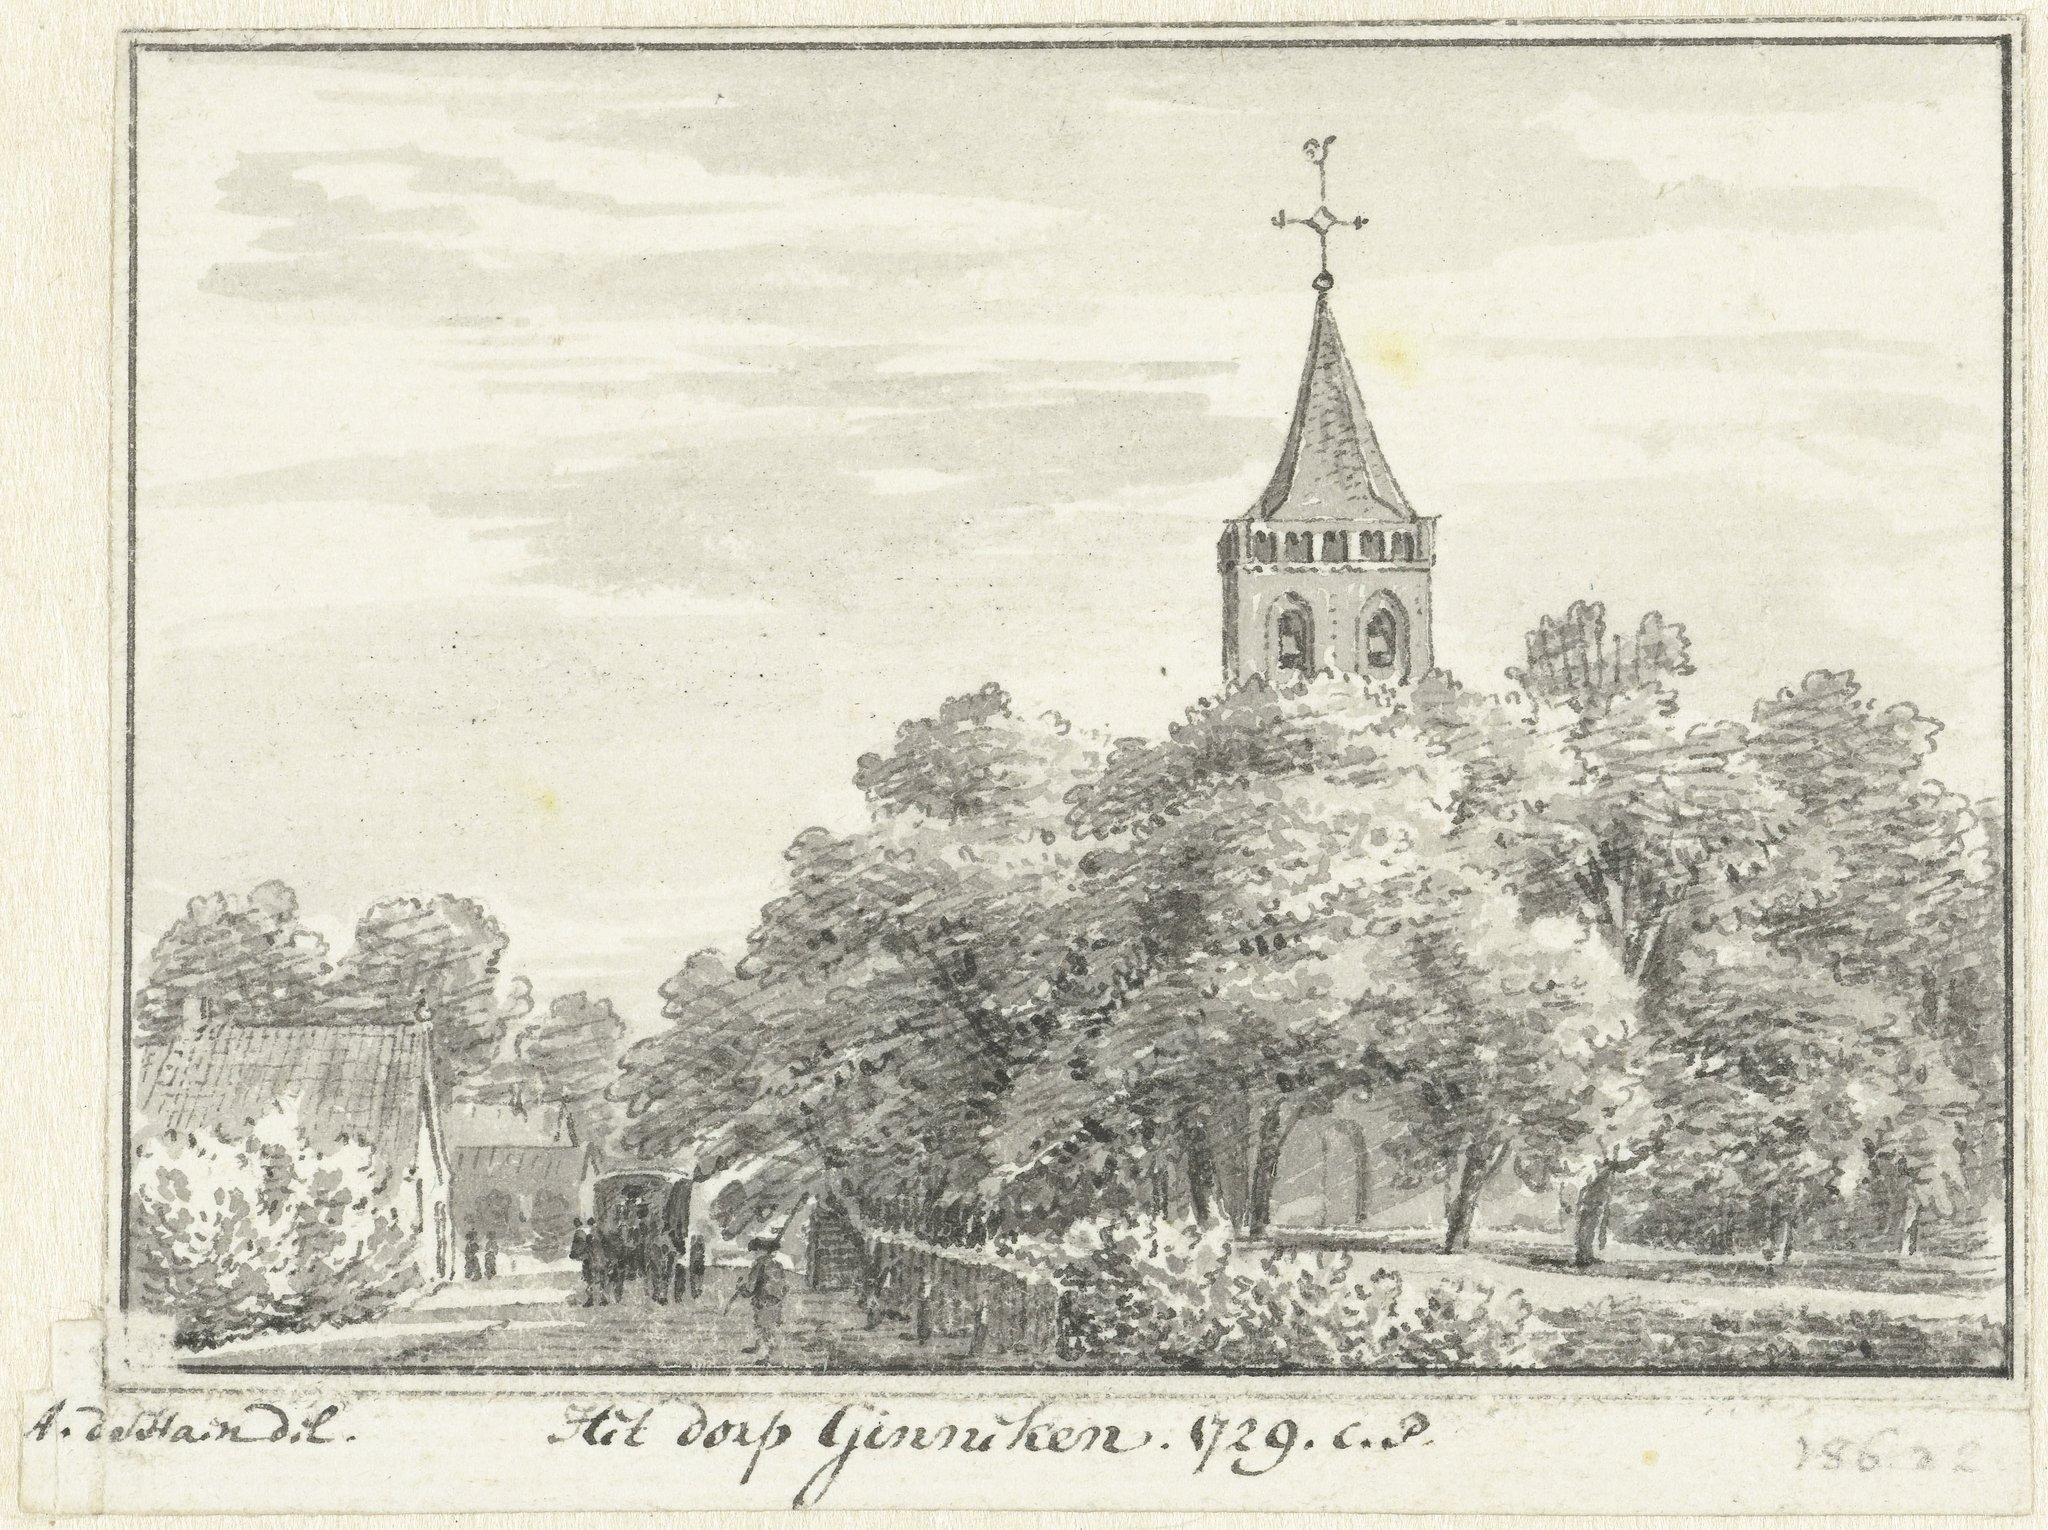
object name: drawing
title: Het dorp Ginneken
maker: abraham de haen (ii)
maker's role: draughtsman, print maker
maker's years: 1707-1748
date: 1729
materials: ink, paper, pencil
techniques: brush, pen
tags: church (exterior), prospect of city, town panorama, silhouette of city